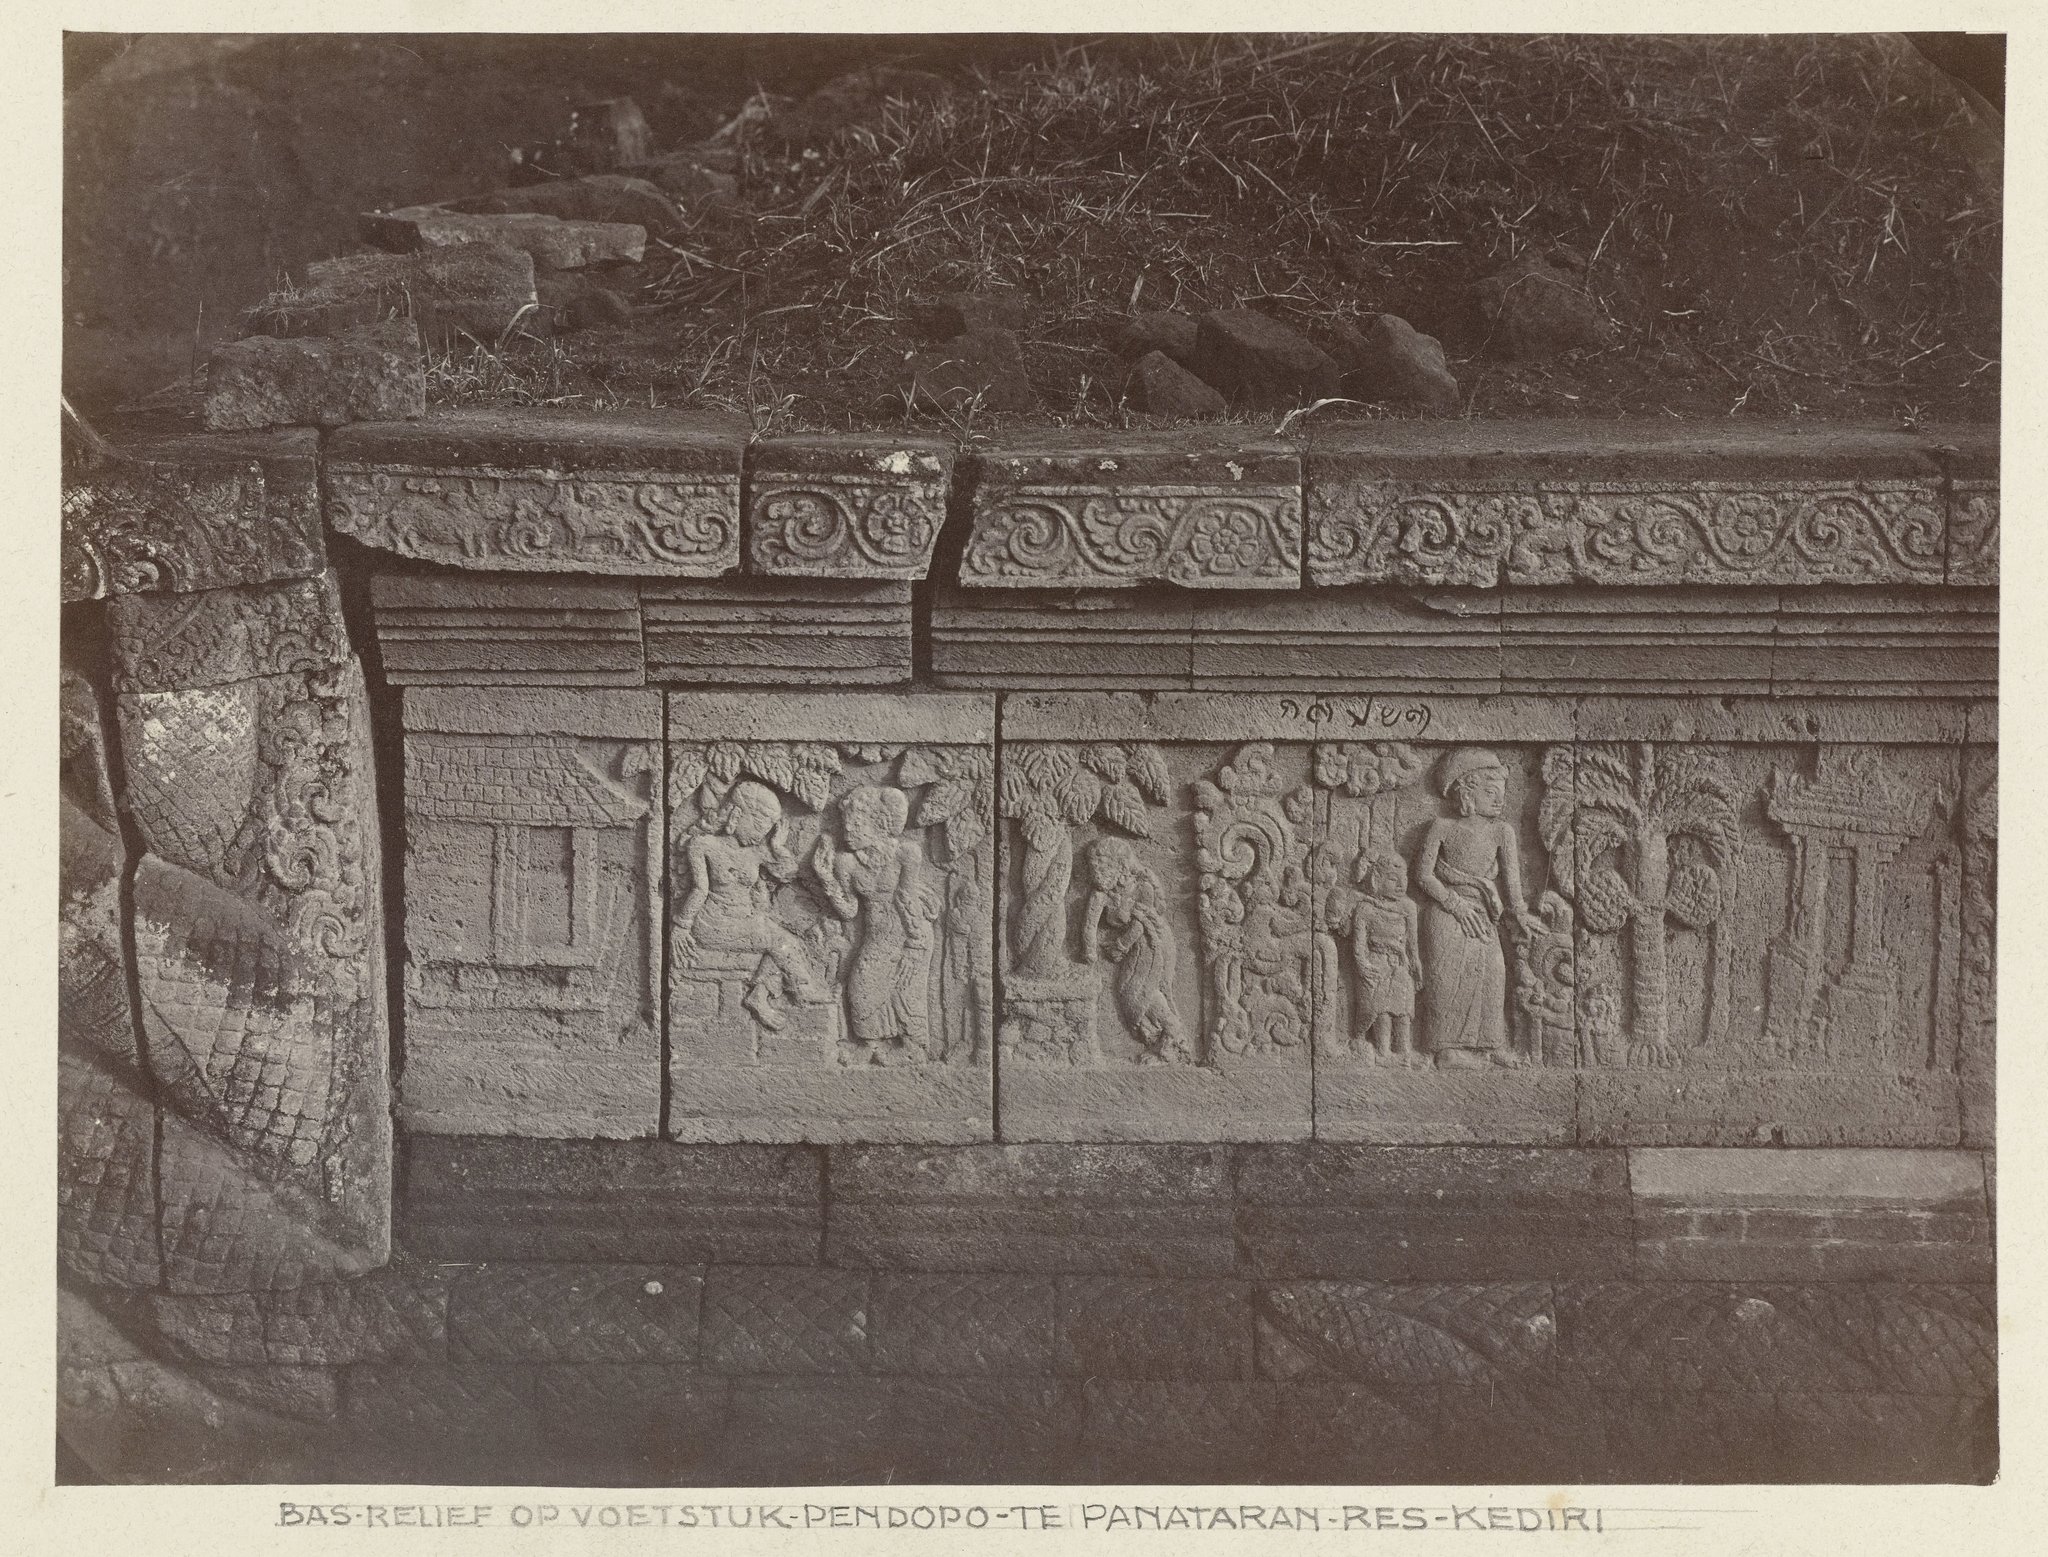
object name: photograph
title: Candi Panataran (Temple Complex), Pendopo Terrace, reliefs 1-4 (Sang Satyawan'story; inscription above no 3 reads batasamat, east side.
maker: isidore kinsbergen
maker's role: fotograaf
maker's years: 1821-1905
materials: cardboard, paper, photographic support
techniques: albumen print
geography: java